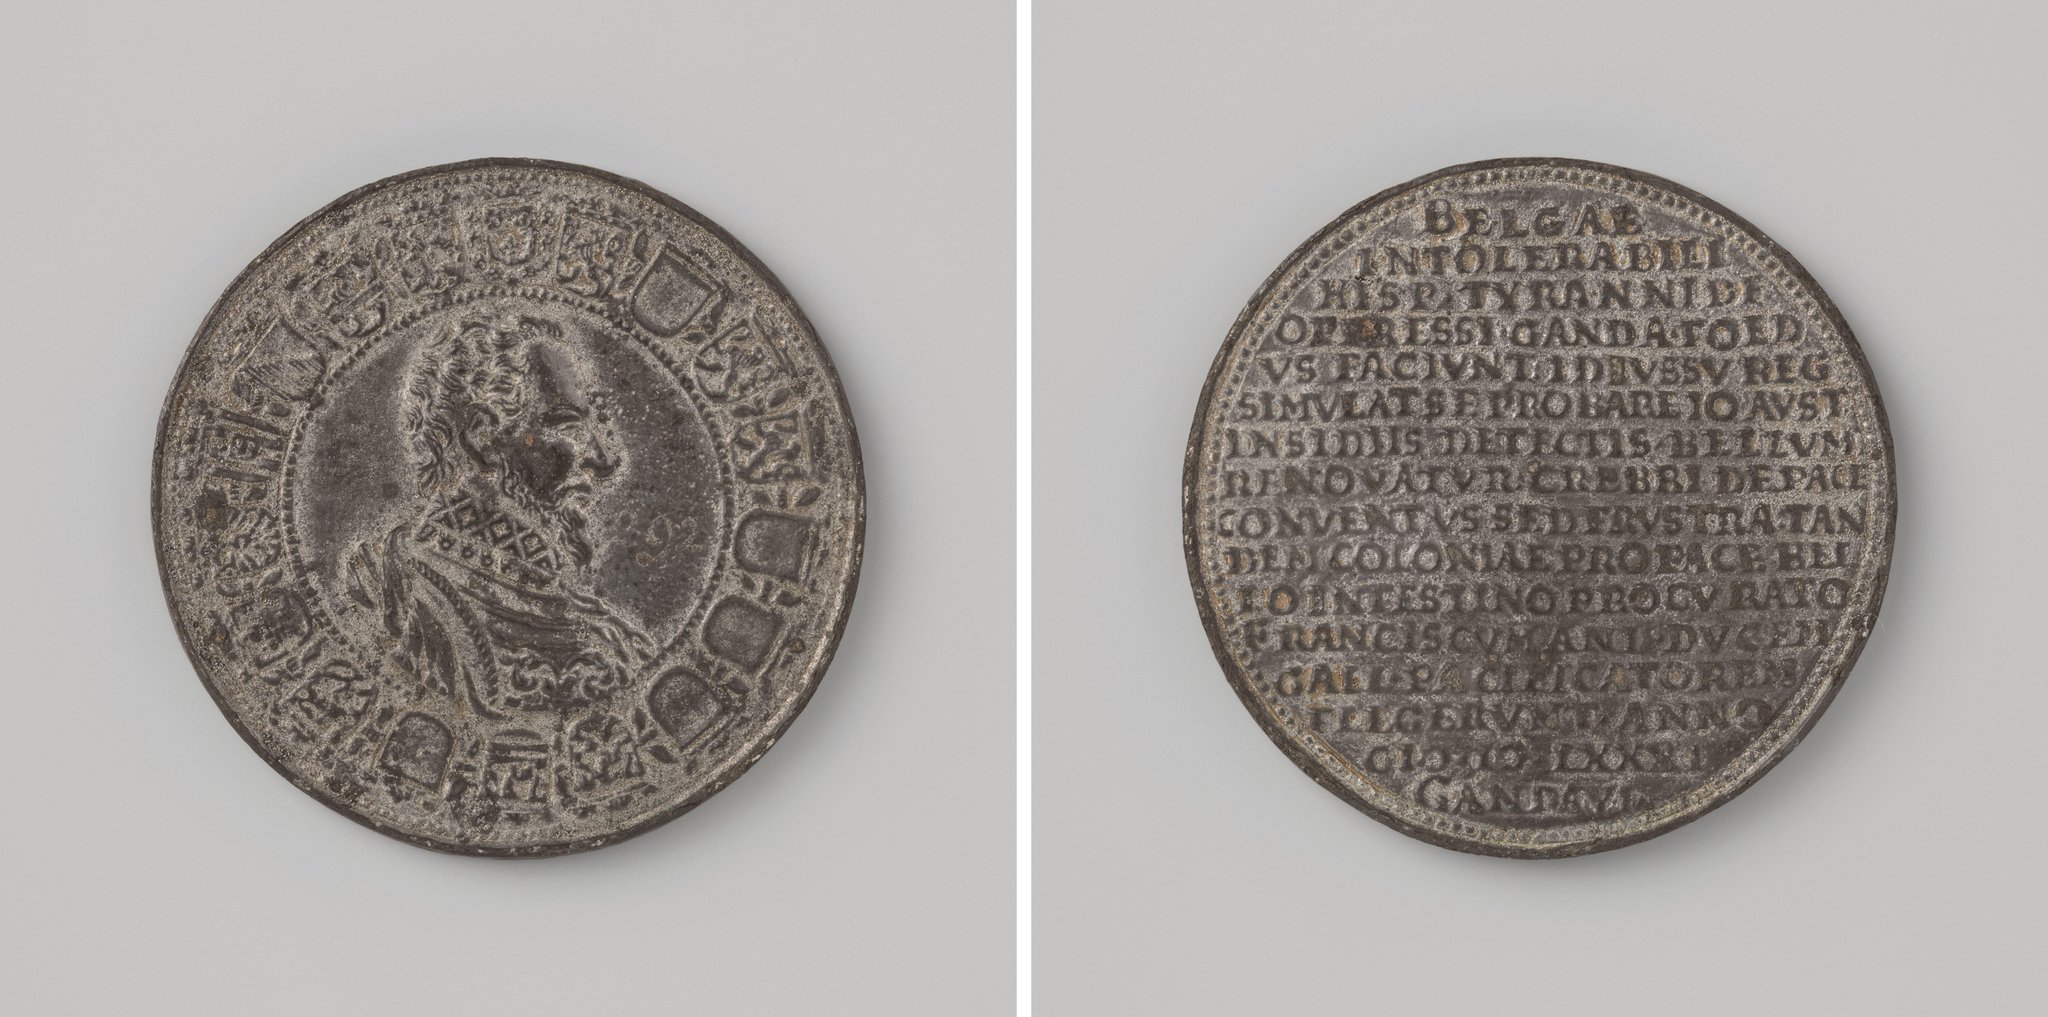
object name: history medal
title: François van Alençon (Anjou) souverein van Brabant en Vlaanderen 1581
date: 1581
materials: tin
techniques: casting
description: Tinnen penning, op de voorzijde het portret van François van Alençon omringd door wapenschilden, op de keerzijde zestien regels tekst.